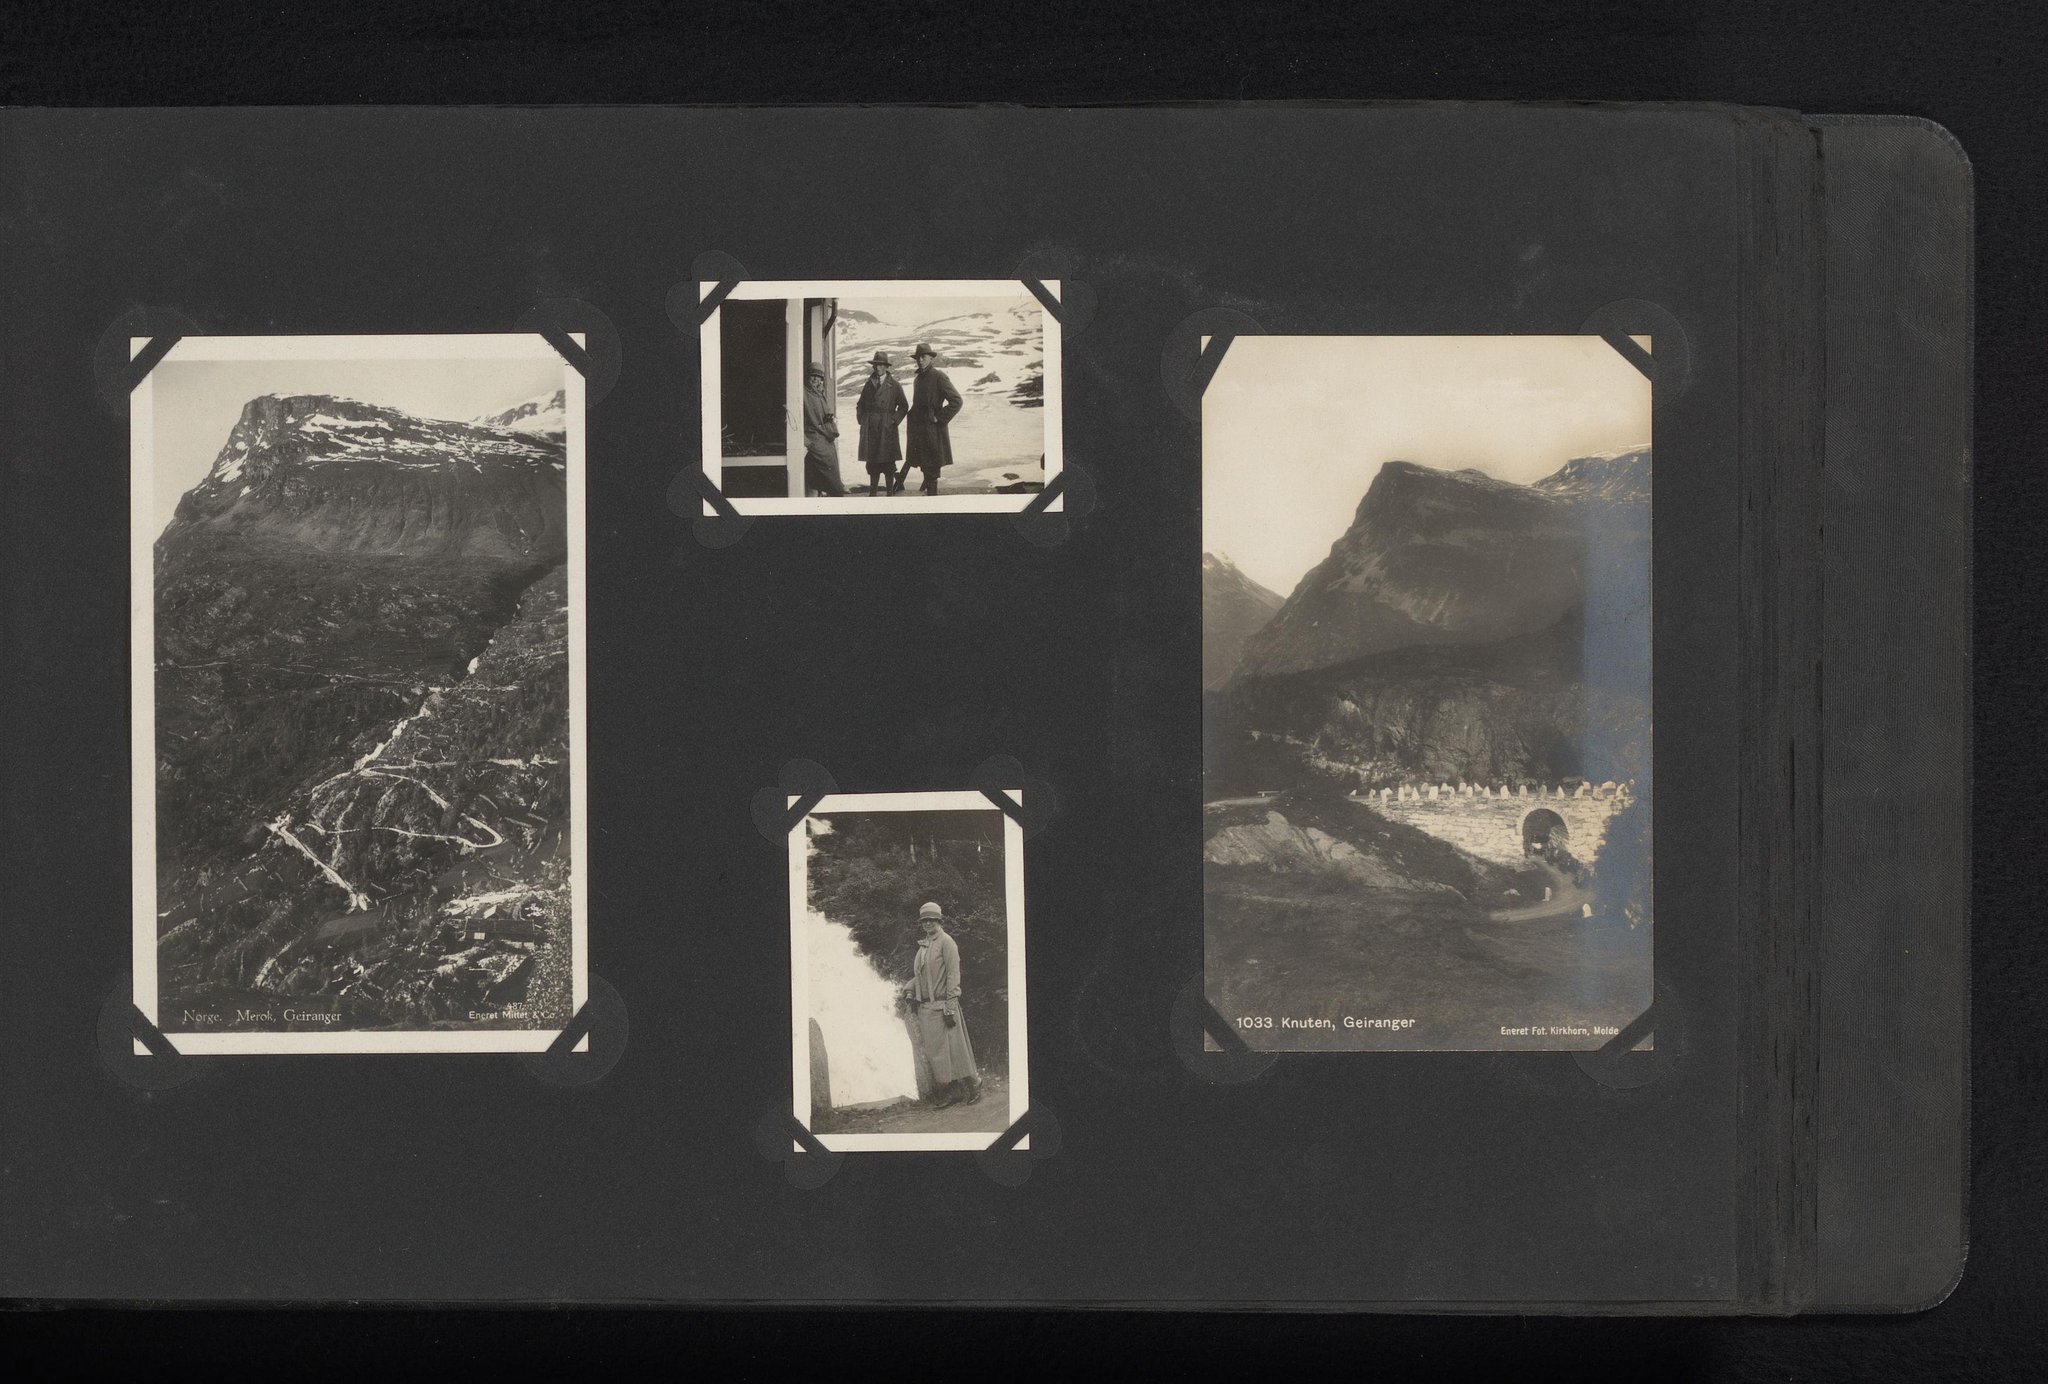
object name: ansichtkaart, prentbriefkaart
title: Vier foto's, waarvan twee prentbriefkaarten, van de bergen rond Geiranger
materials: paper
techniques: gelatin silver print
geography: norway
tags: the hague, caroline louise van den berg-van den berg, amsterdam, carel frederik van den berg (cay), frank willem van den berg (1912-1998), mountains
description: Deze foto's maken deel uit van een album.